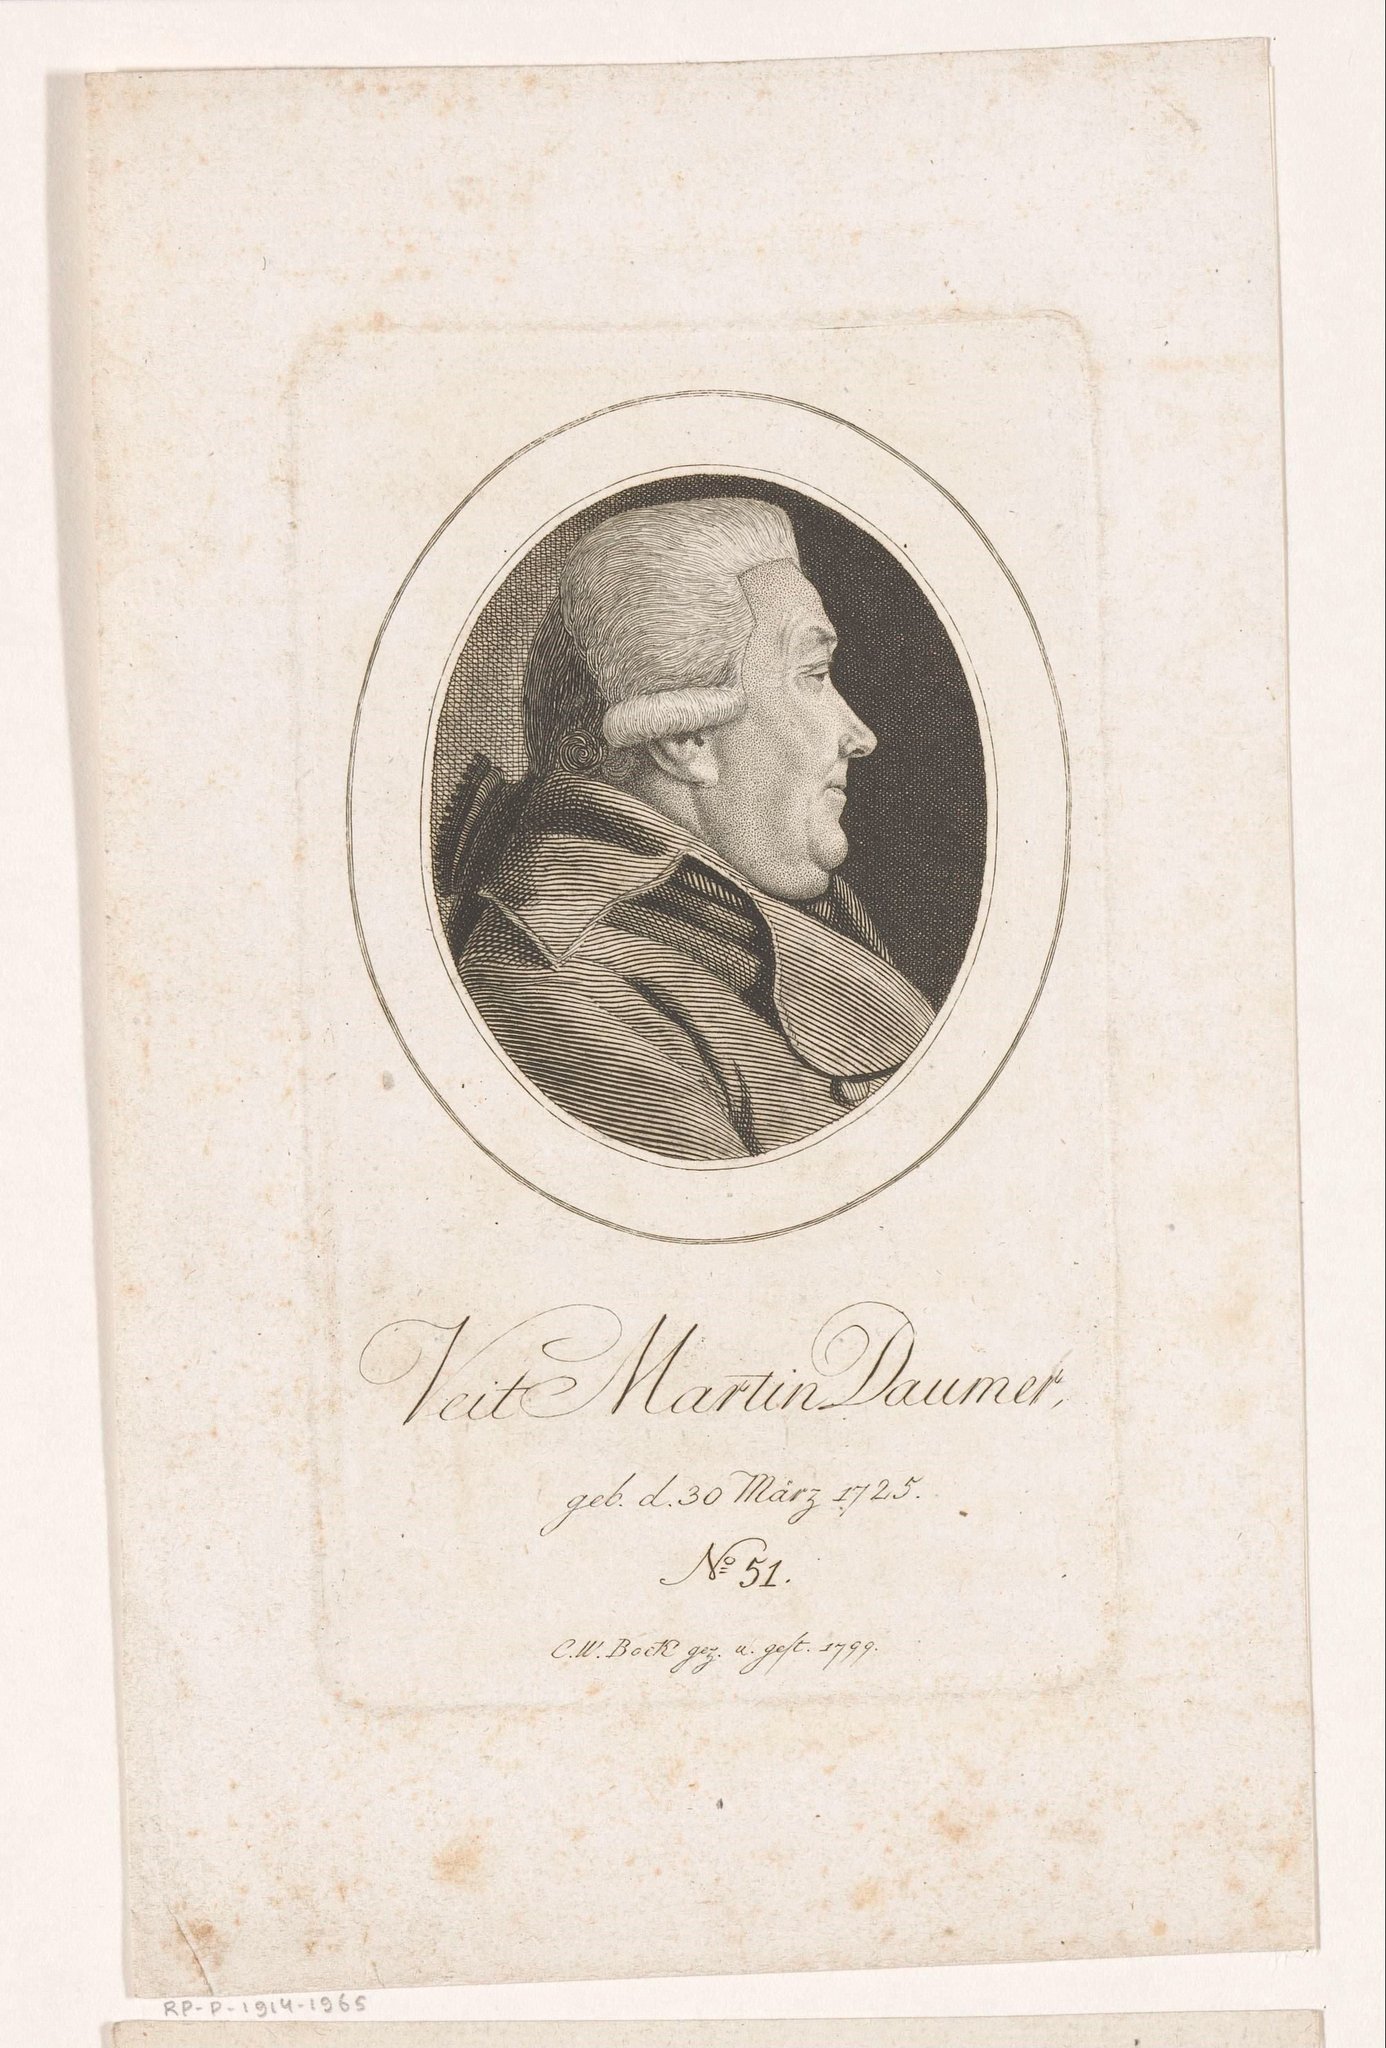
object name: print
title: Portret van Veit Martin Daumer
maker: christoph wilhelm bock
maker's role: print maker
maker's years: 1755-1836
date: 1799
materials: paper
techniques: engraving, etching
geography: nuremberg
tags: historical persons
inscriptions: collector's mark: Lugt 2228